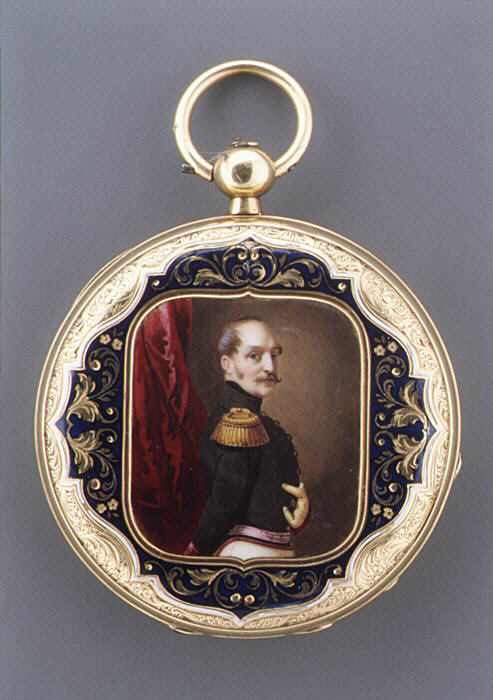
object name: watch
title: Watch with a portrait of Nicholas I, czar of Russia (r. 1825–55)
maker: firm of perret & cie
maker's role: maker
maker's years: 1840-1850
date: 1850-1855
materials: enamel, gold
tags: men,portraits